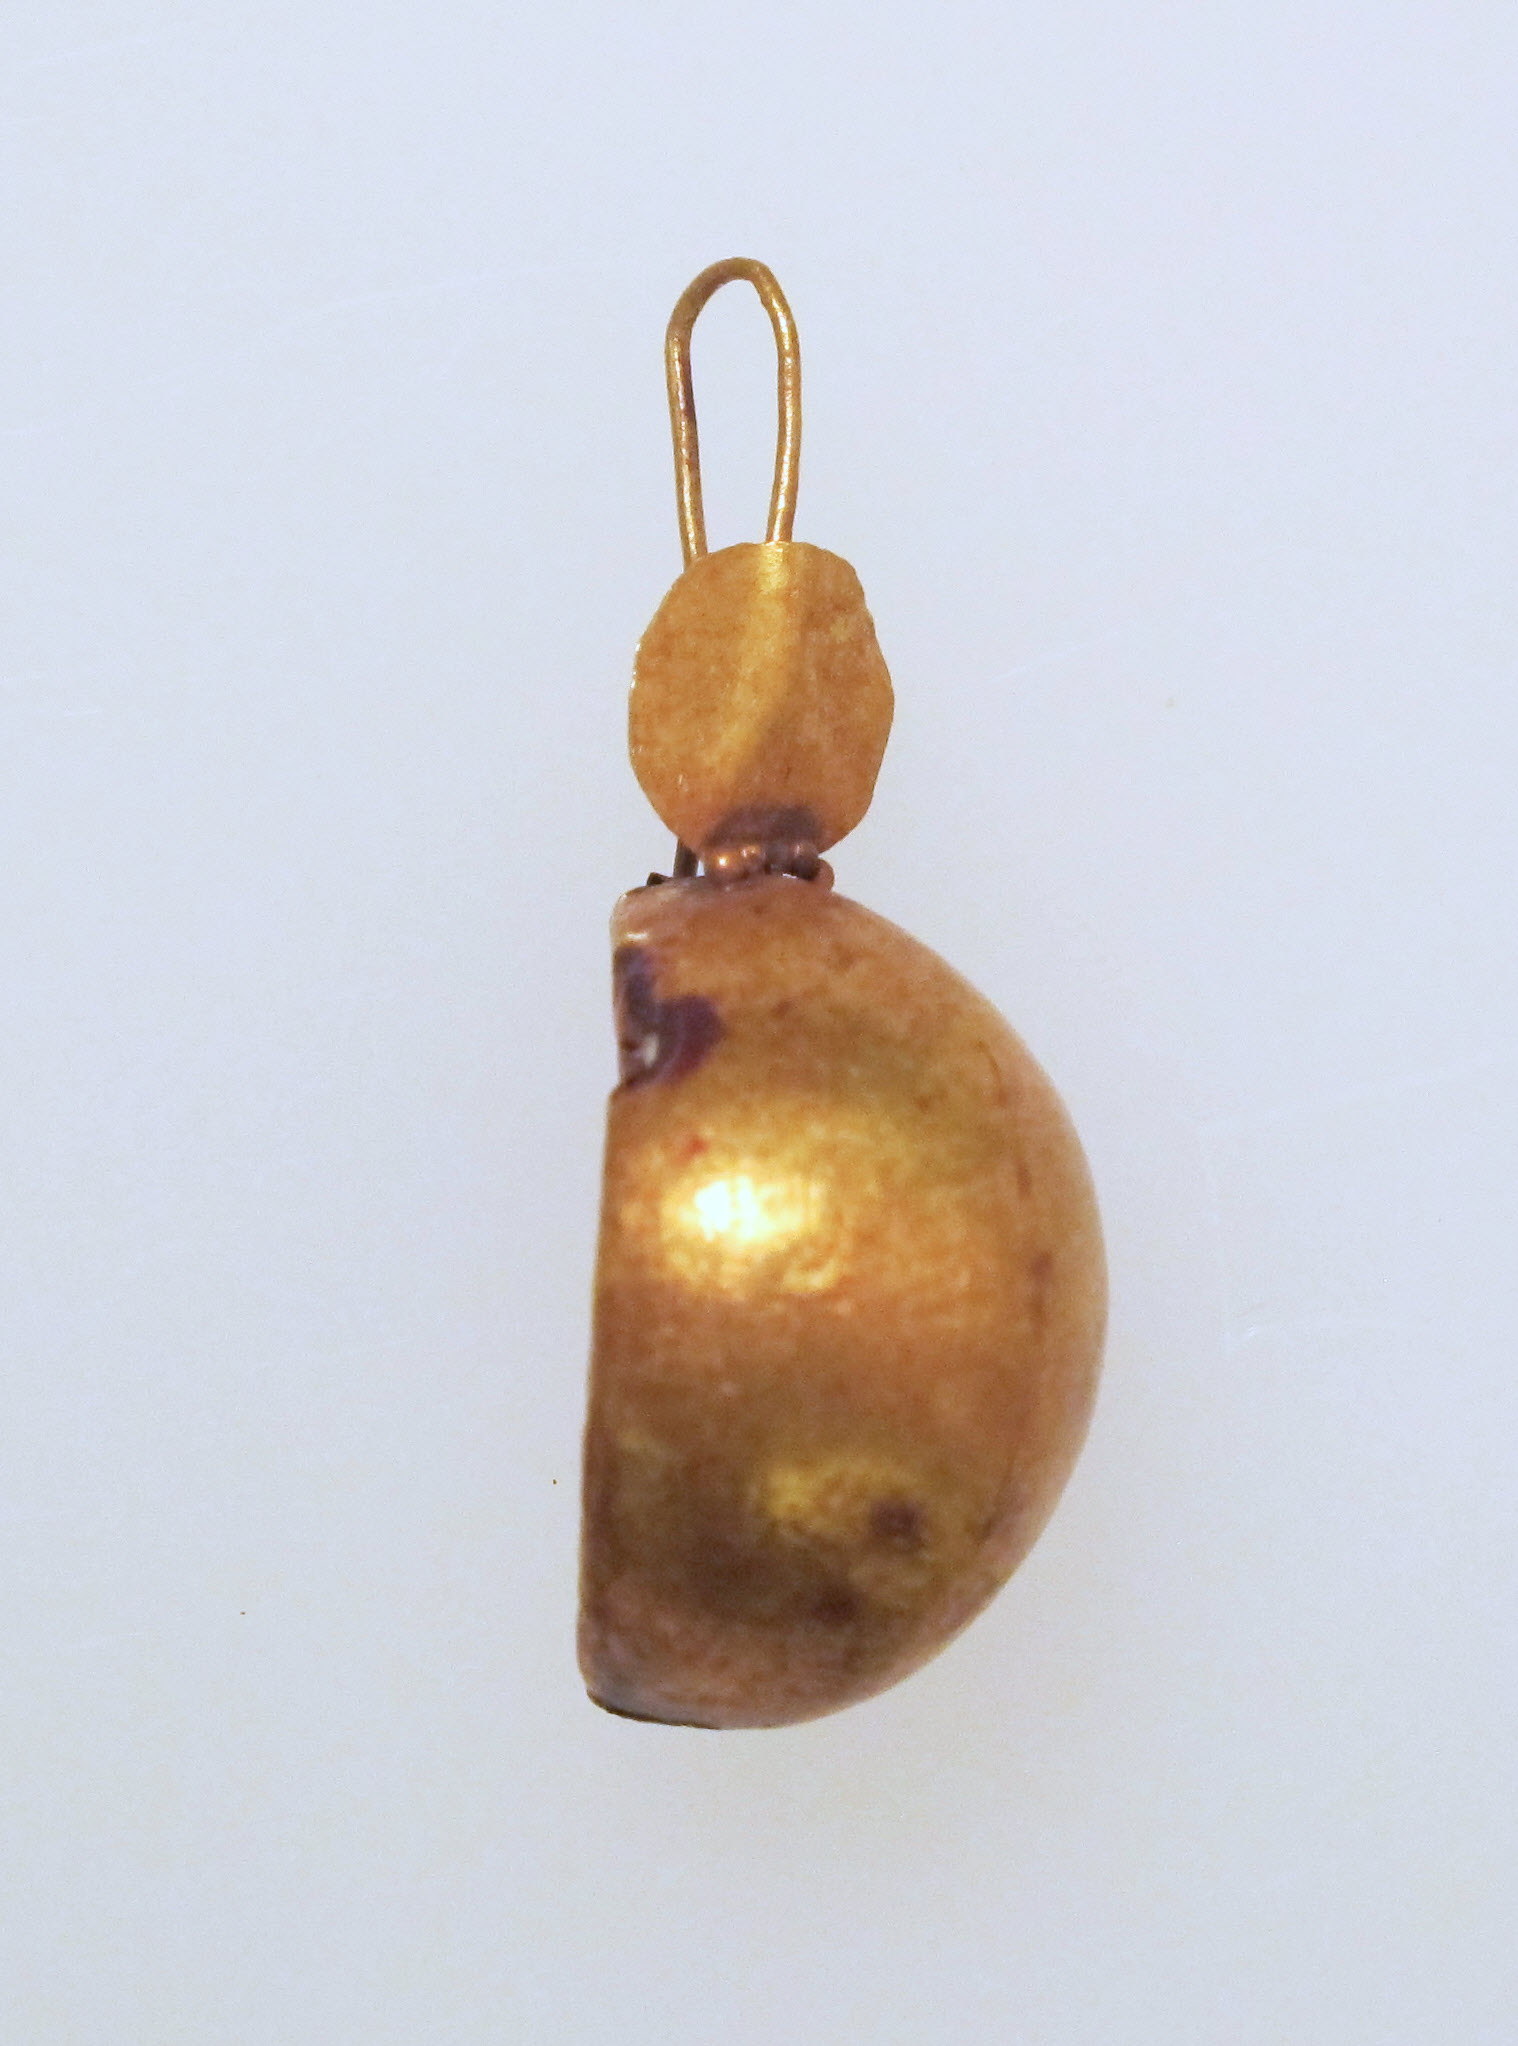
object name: earring hook type with disc of thin foil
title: Earring-hook type with discs of thin foil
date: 7000 BCE-330 CE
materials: gold